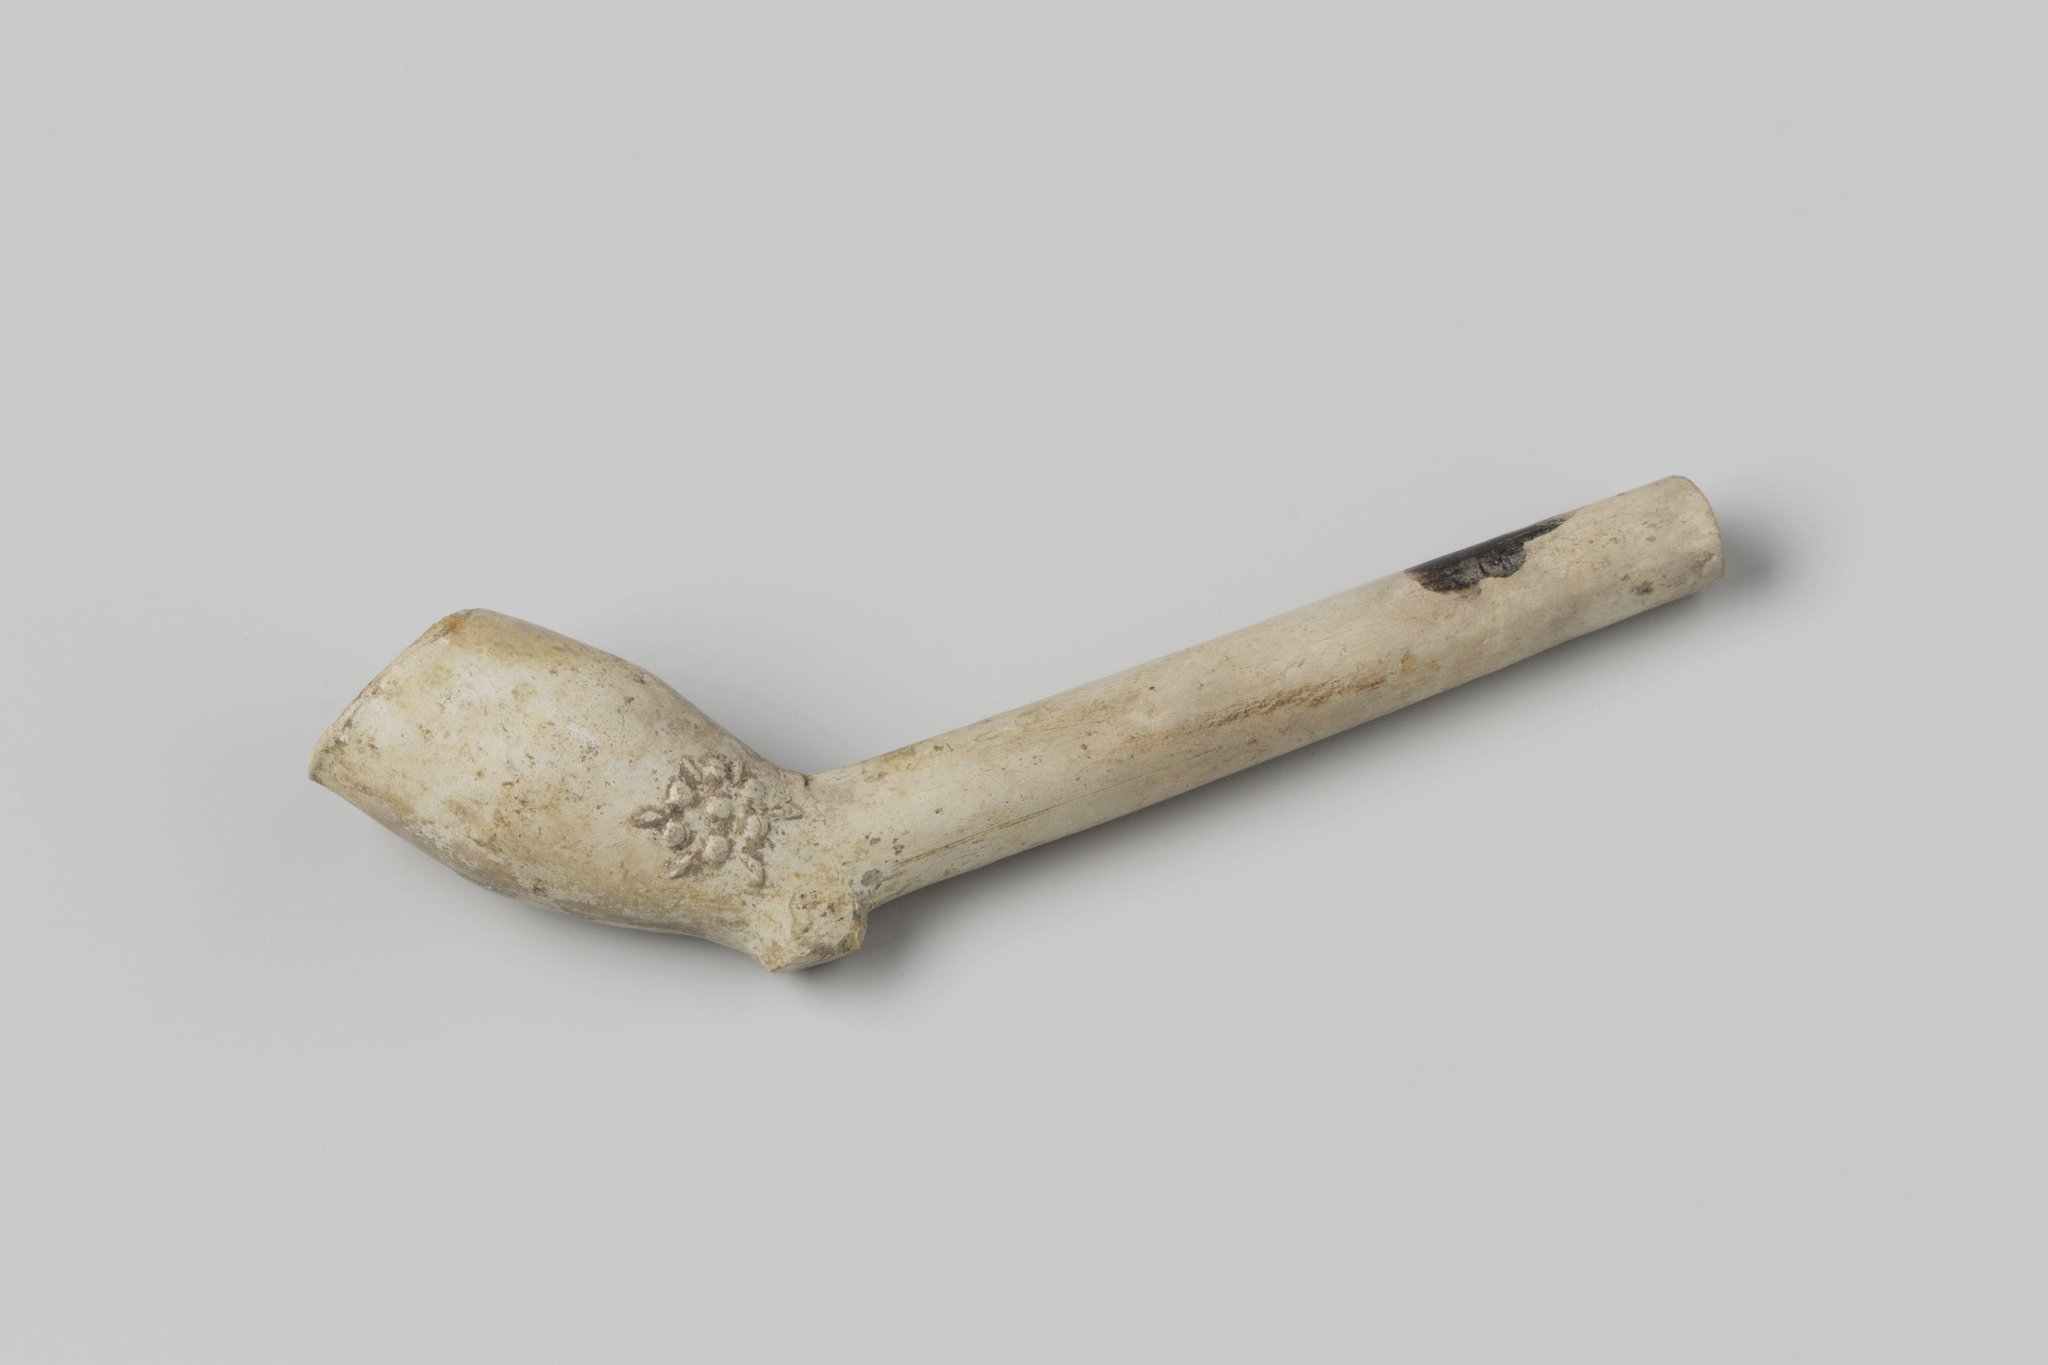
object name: pipe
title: Gedeelte van een pijpaarden pijp met twee stervormige bloemen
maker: Anonymous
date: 1400-1950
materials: earthenware, clay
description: Gedeelte van een pijpaarden pijp met twee stervormige bloemen.